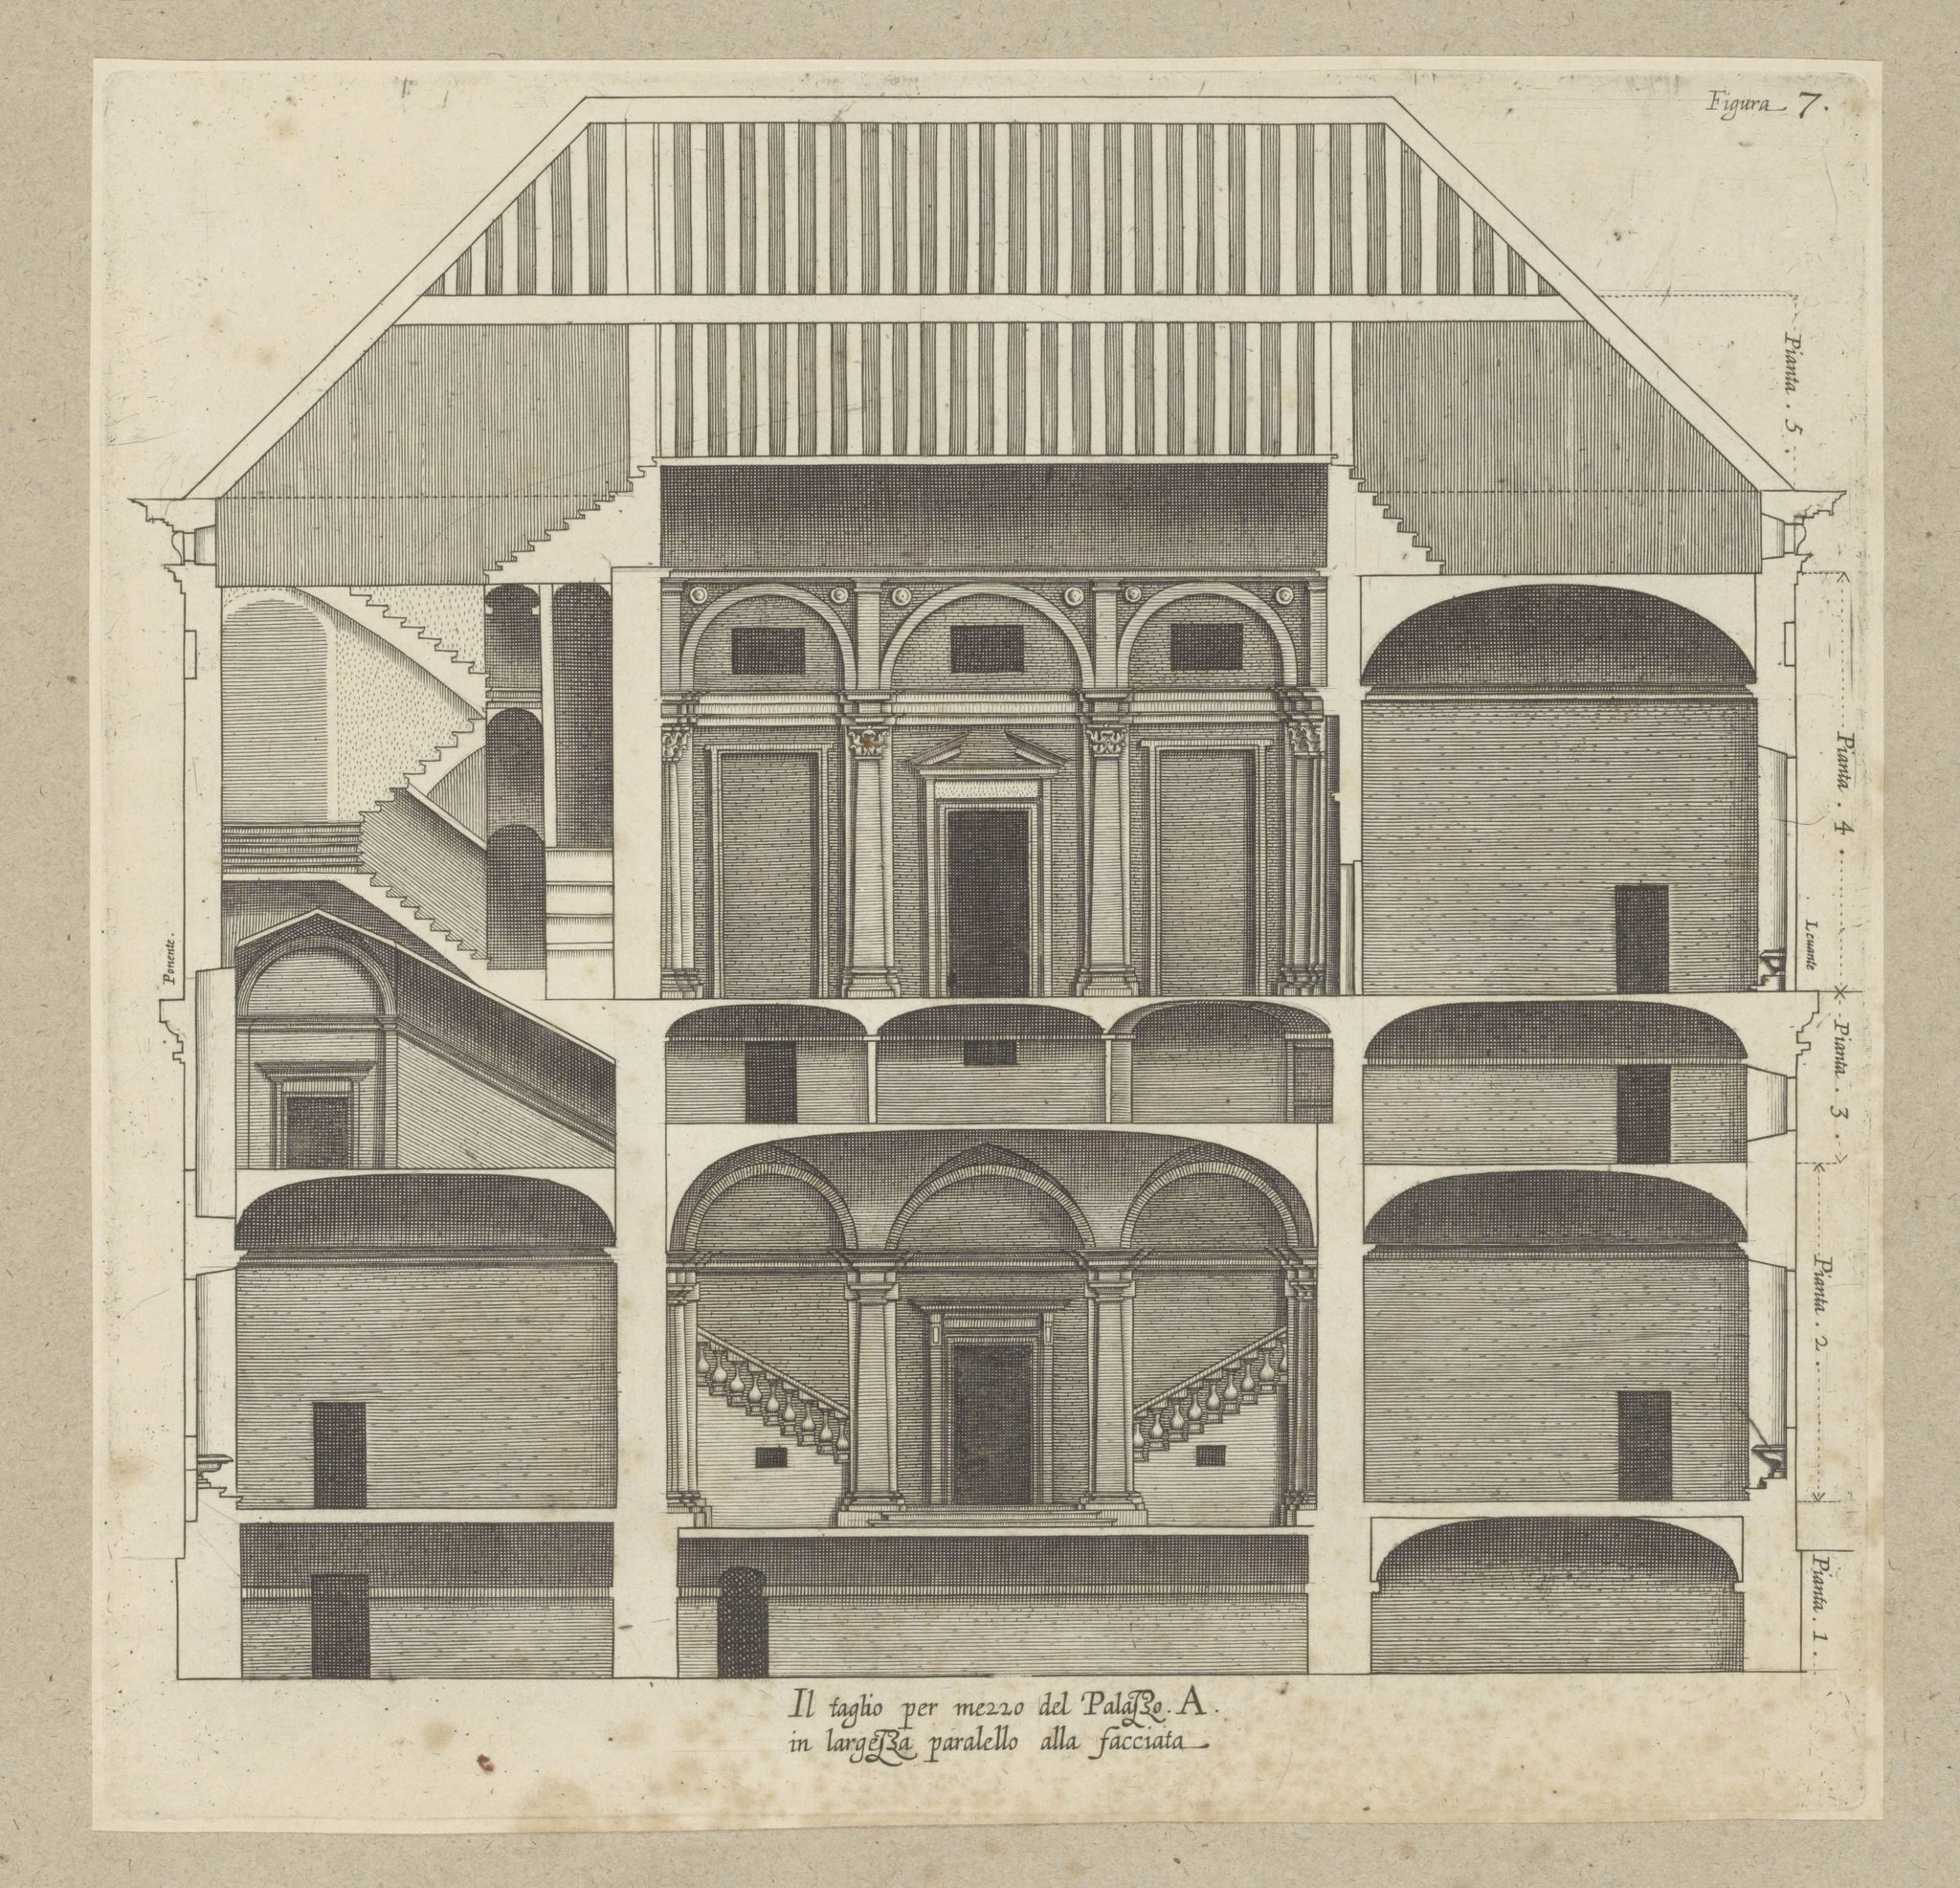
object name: print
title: Dwarsdoorsnede van het Palazzo Carrega-Cataldi te Genua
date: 1622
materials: paper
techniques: engraving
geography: antwerp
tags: hôtel, i.e. small palace in city - aa - civic architecture: inside, section ~ architectural design or model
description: Deze prent maakt deel uit van een album.